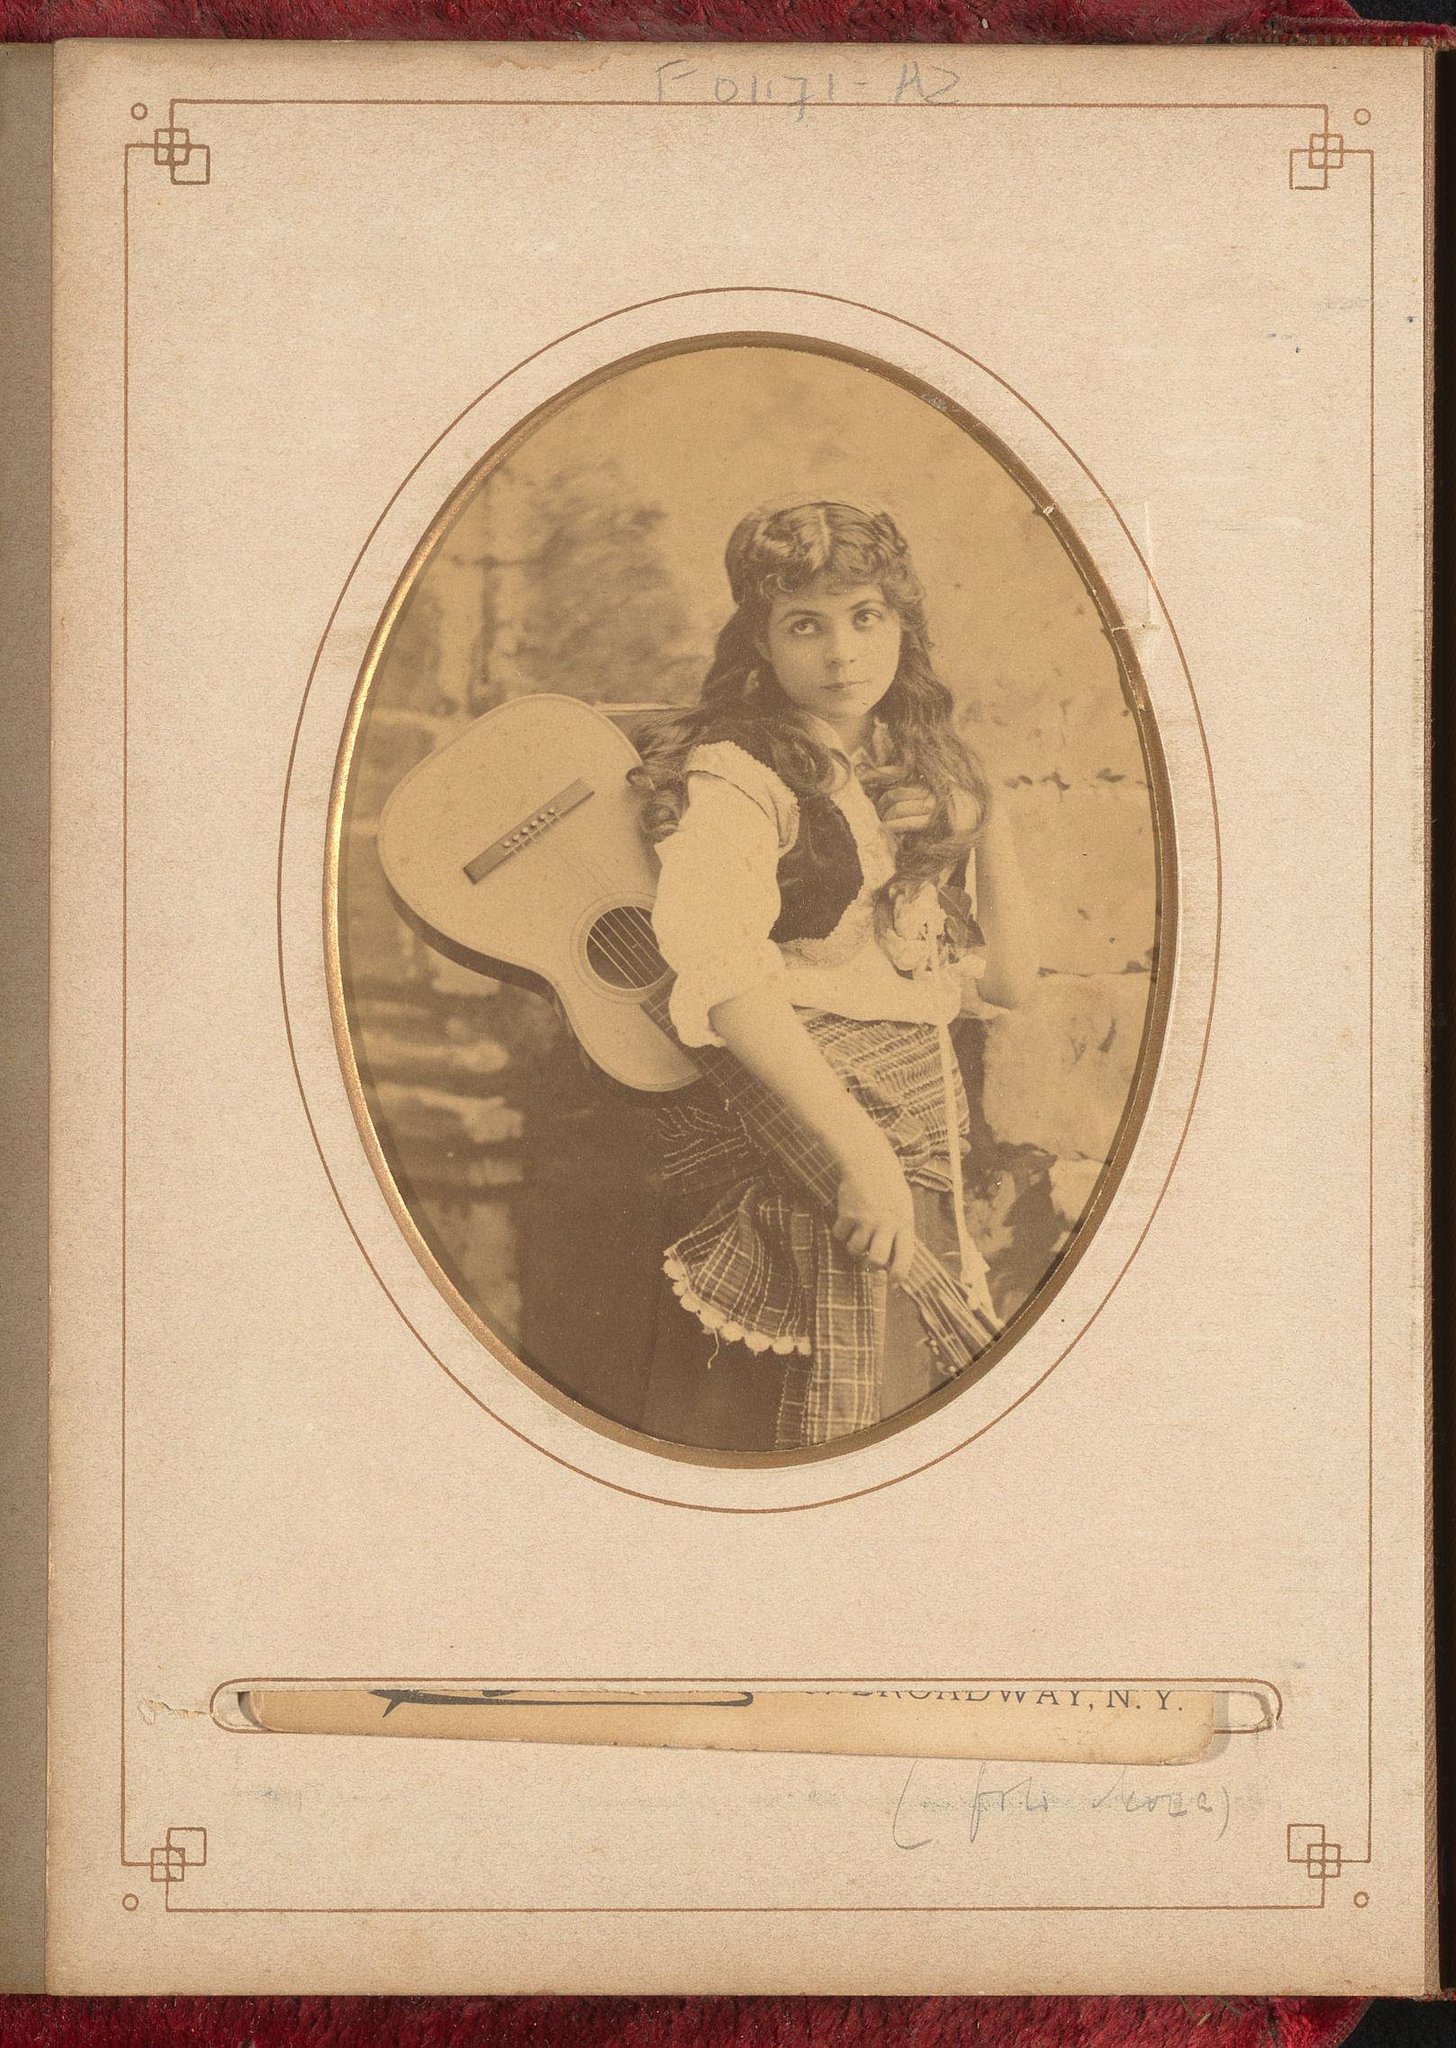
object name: cabinet photograph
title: Portret van een jonge vrouw verkleed als Roma met gitaar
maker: josé maria mora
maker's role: fotograaf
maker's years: 1849-1926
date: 1870-1900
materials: cardboard, photographic support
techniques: albumen print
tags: adolescent, young woman, maiden, wandering communities: romani or roma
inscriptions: name: ‘Mora 707 Broadway, N.Y.’